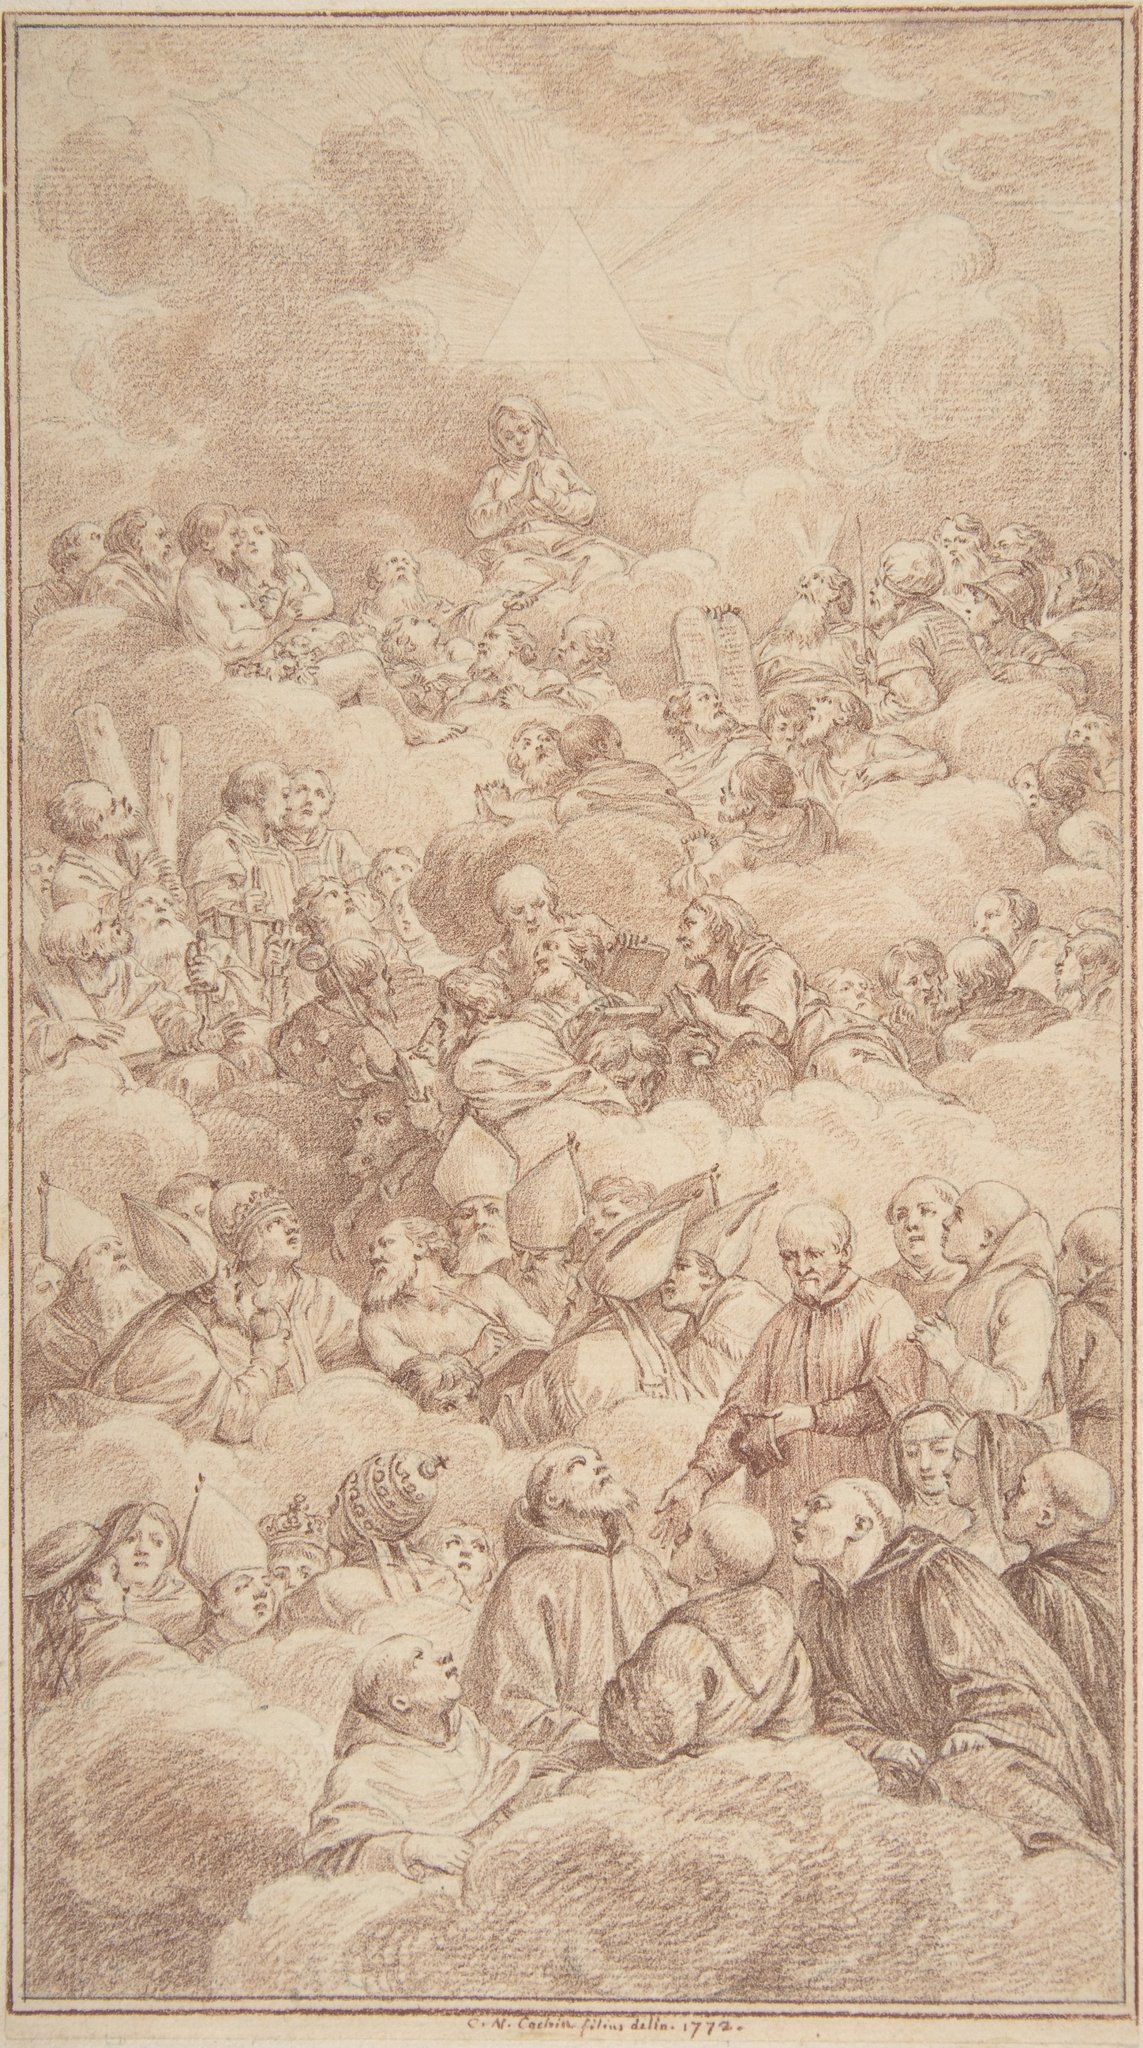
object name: drawing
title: The Company of Saints in Glory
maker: charles nicolas cochin ii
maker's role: artist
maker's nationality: french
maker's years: 1715-1790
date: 1772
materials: chalk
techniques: drawing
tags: human figures,saints